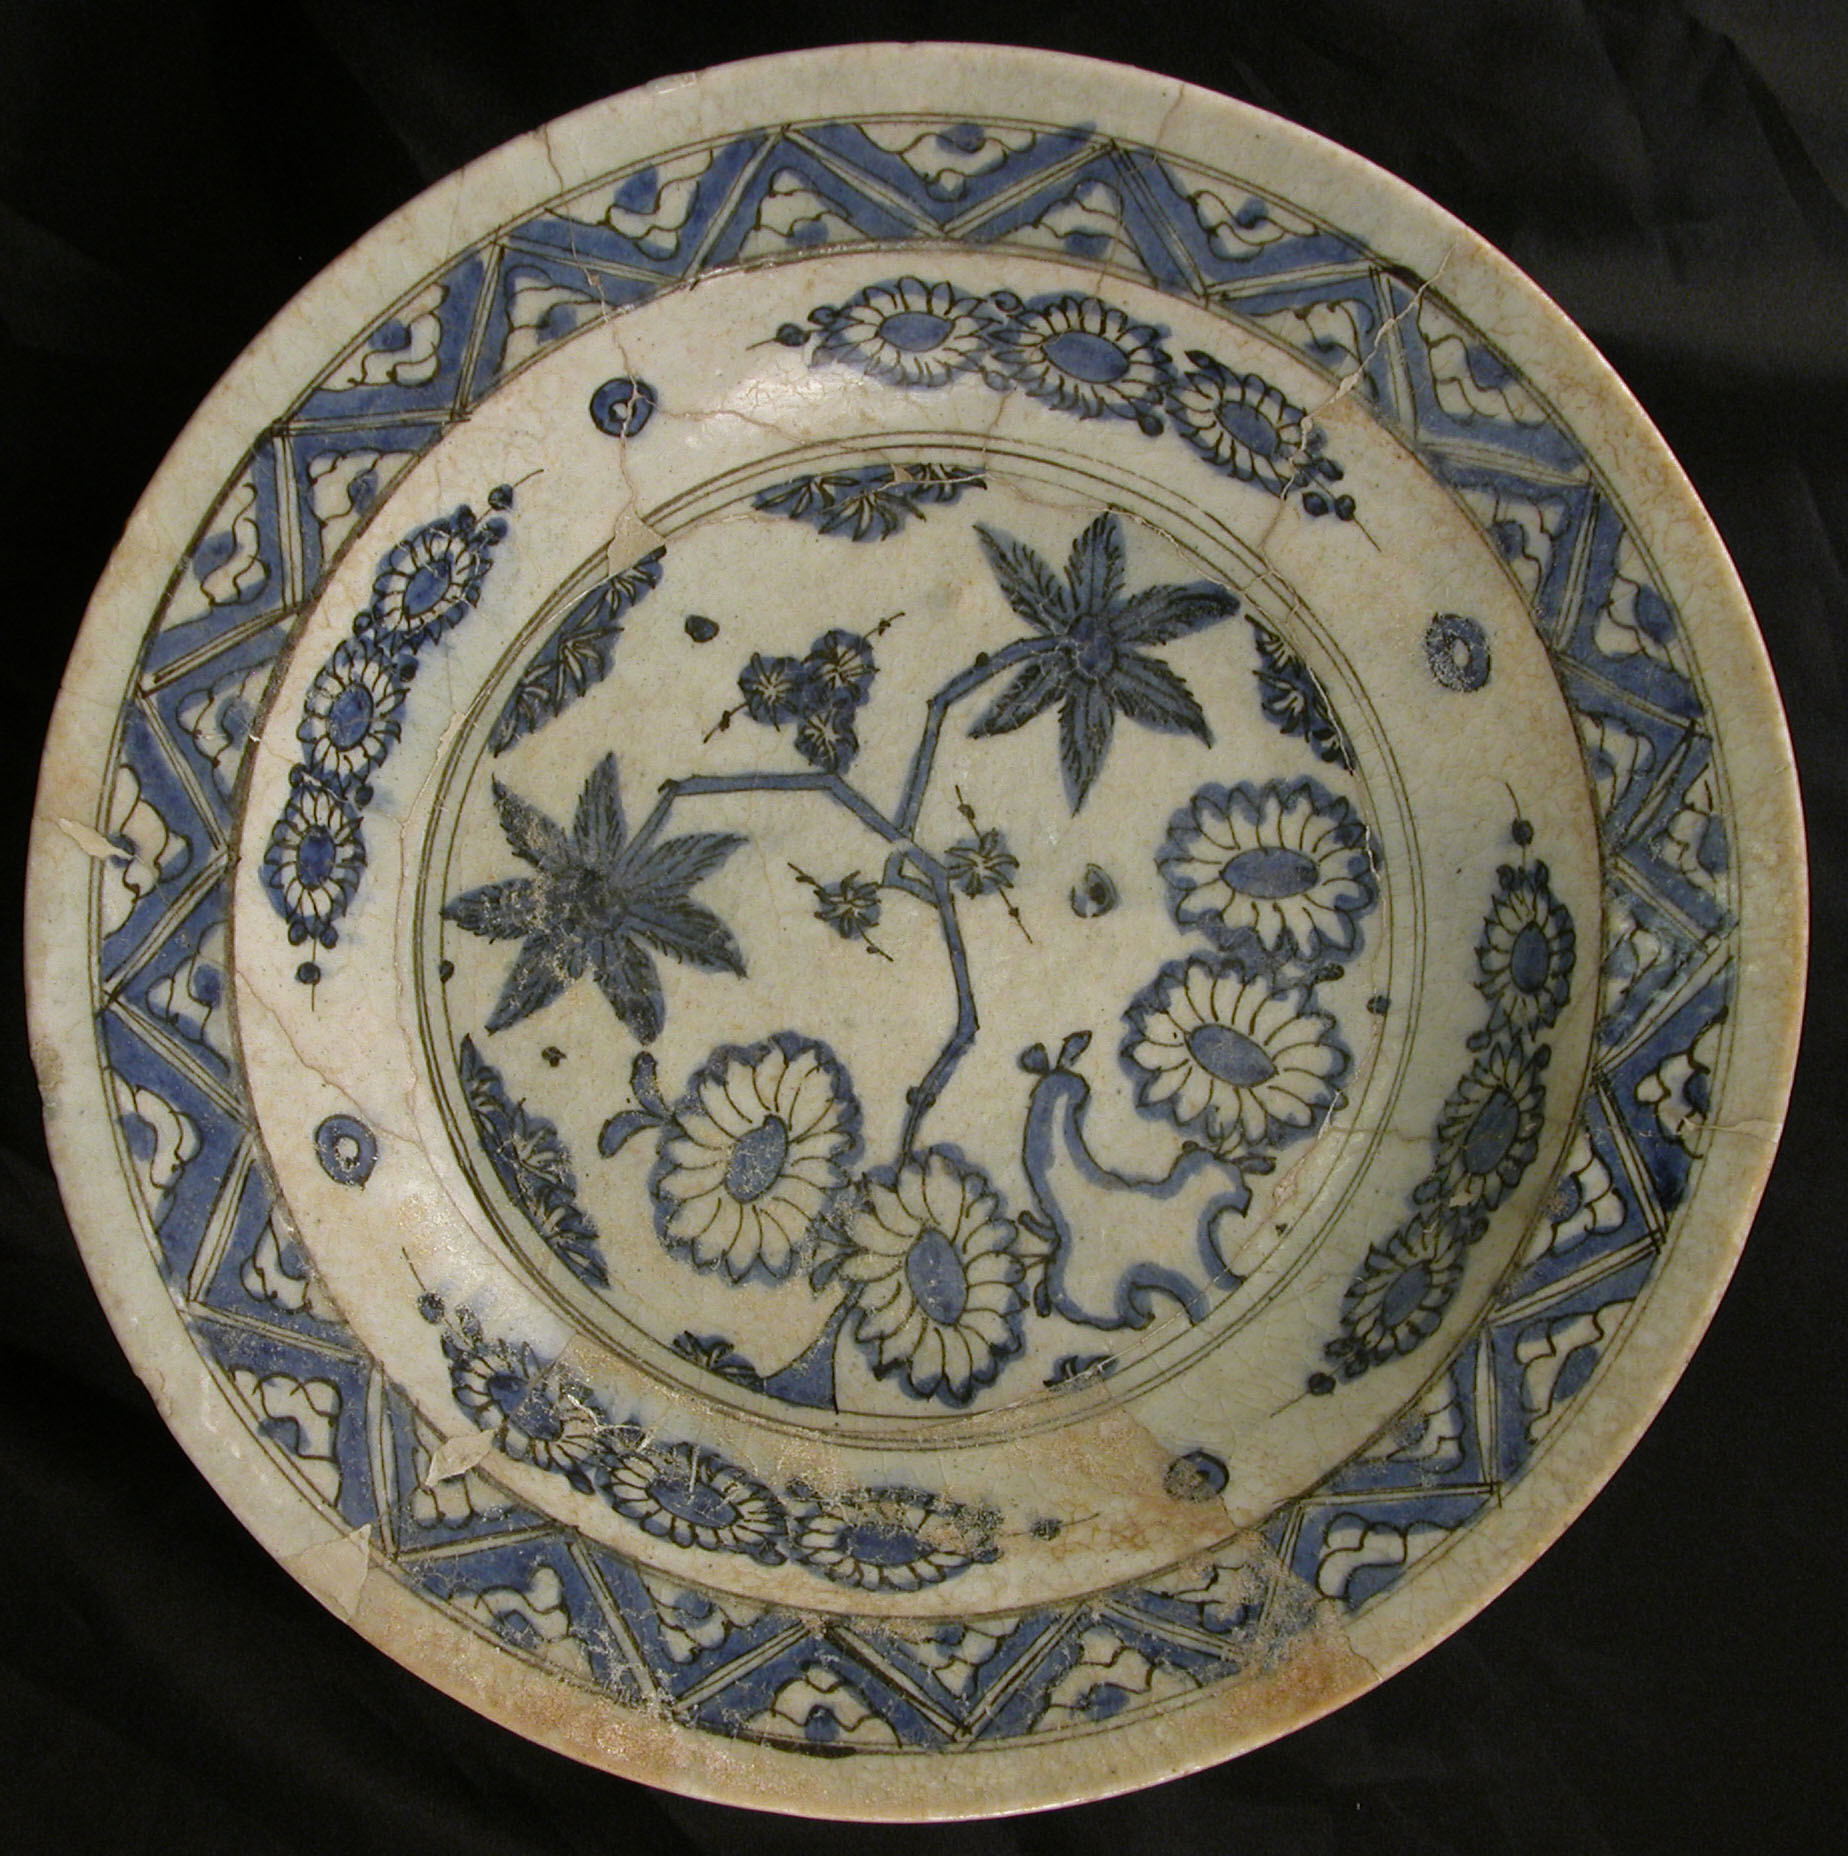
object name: dish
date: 1567-1633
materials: glaze, stonepaste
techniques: painting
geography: iran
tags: flowers